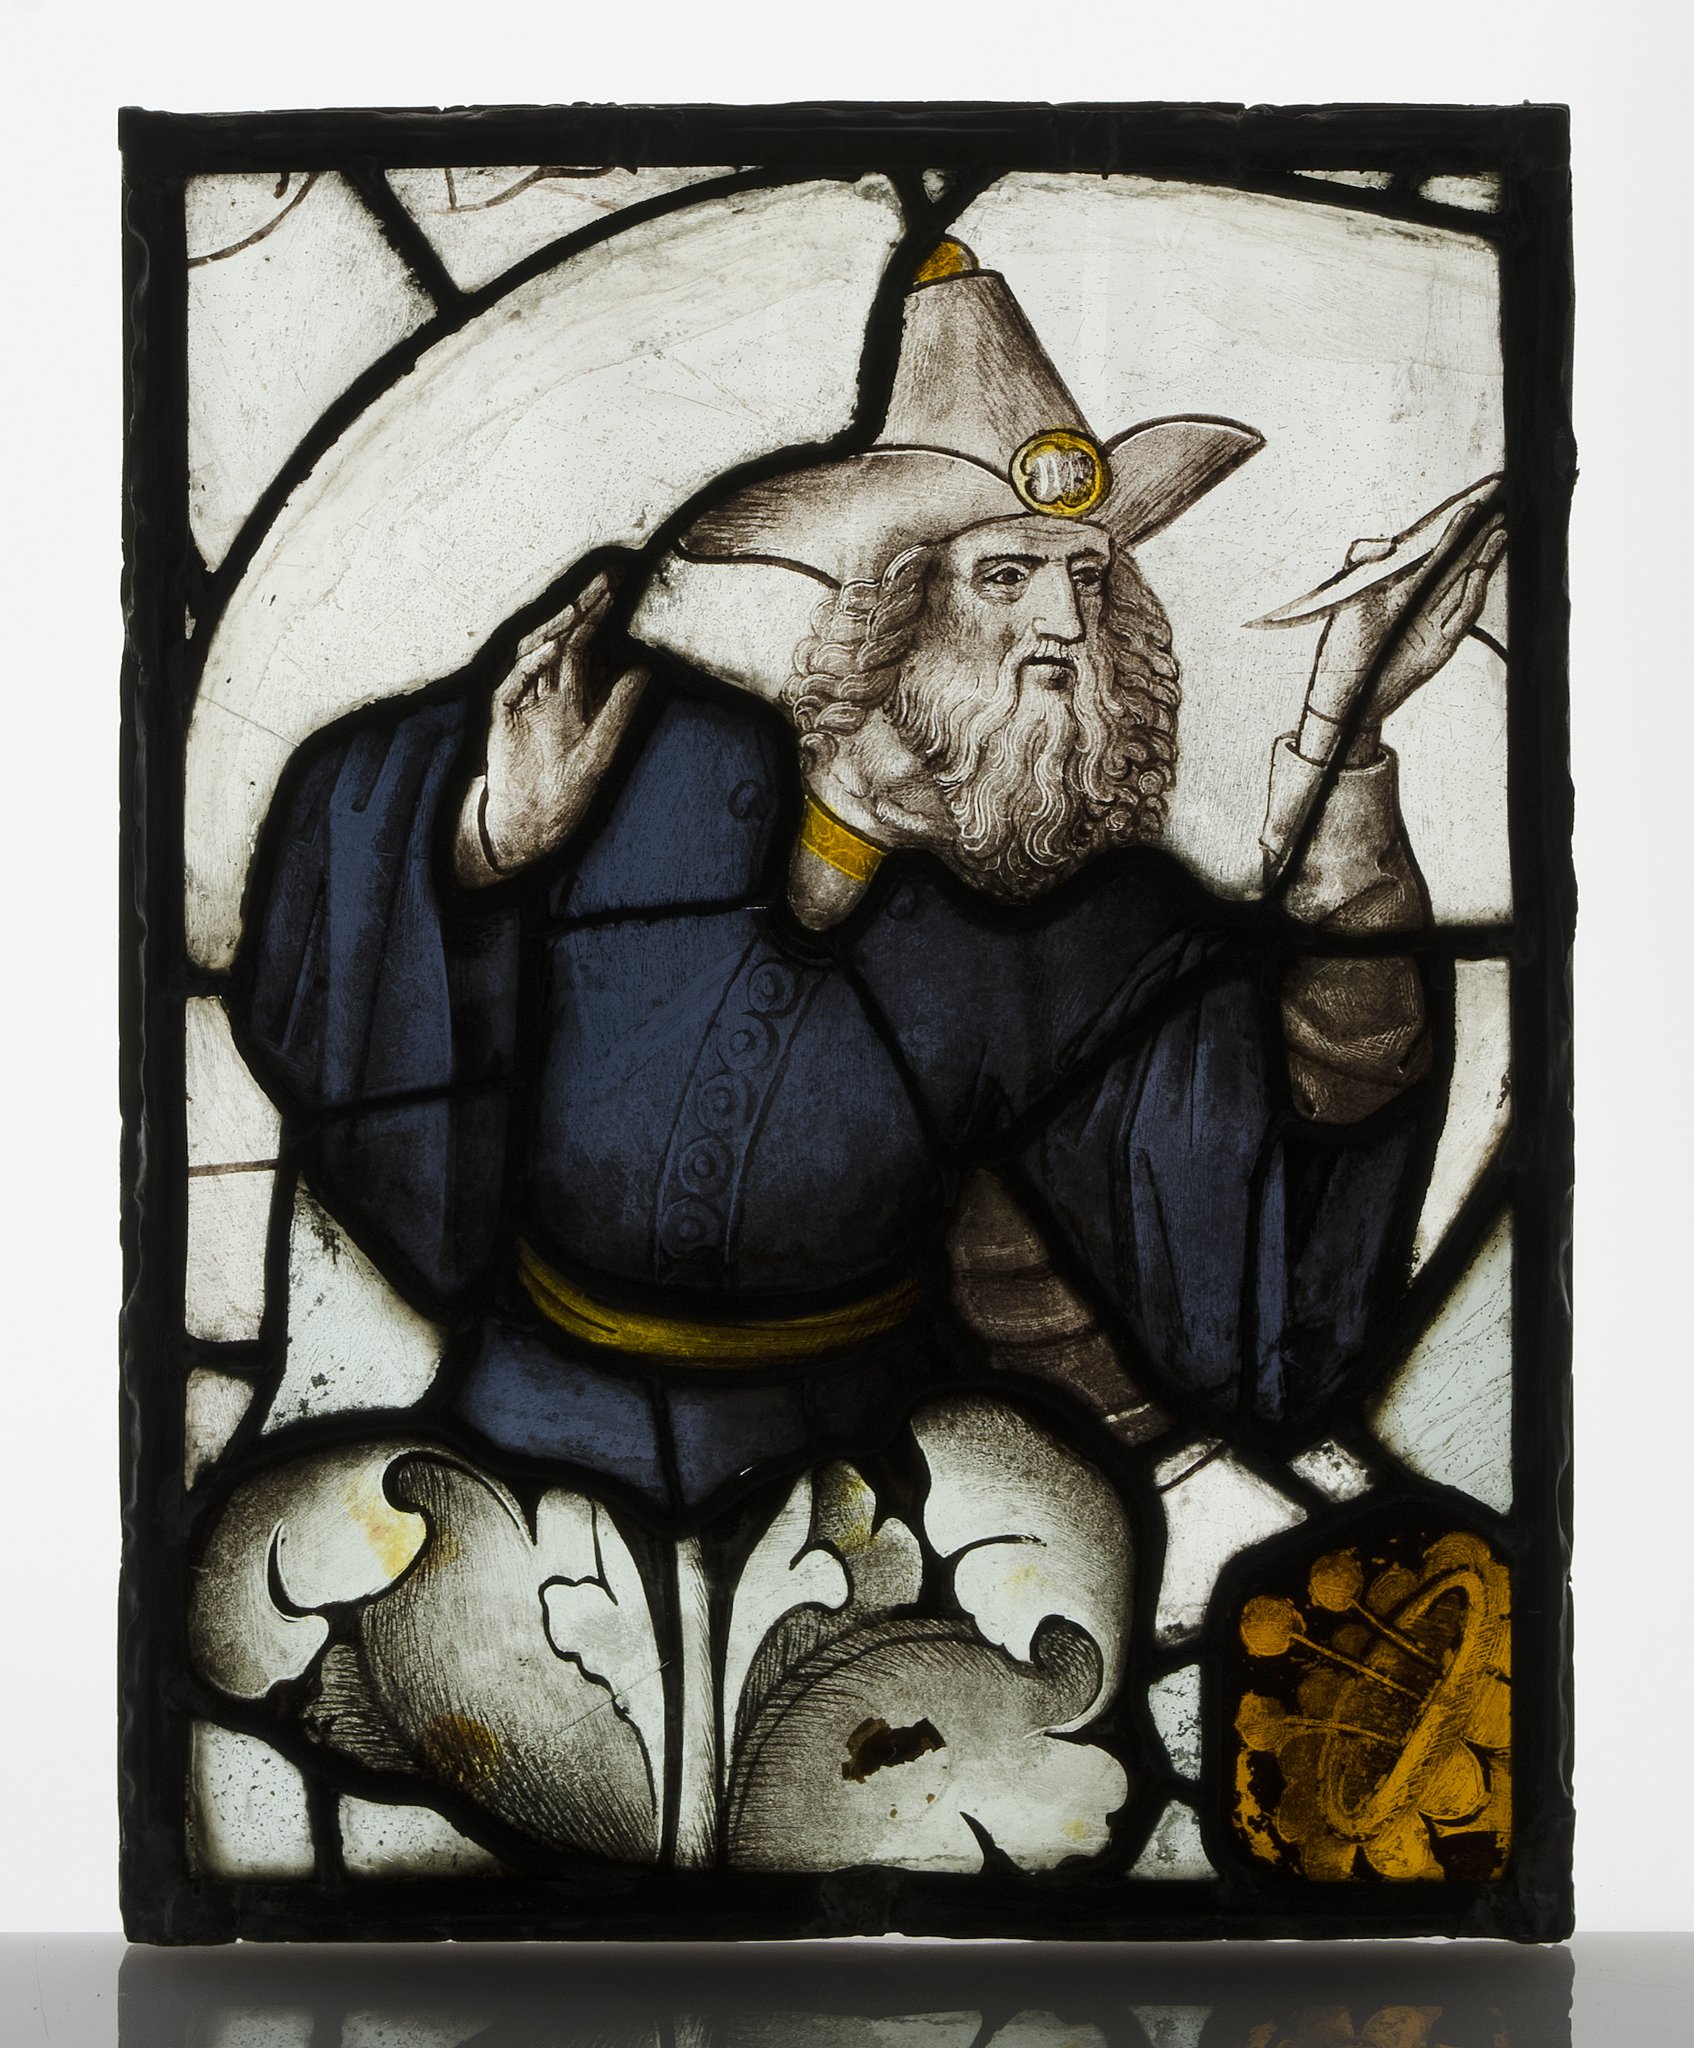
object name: panel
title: An Unidentified Prophet, from a Tree of Jesse Window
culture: british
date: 1500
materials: glass, metal, paint